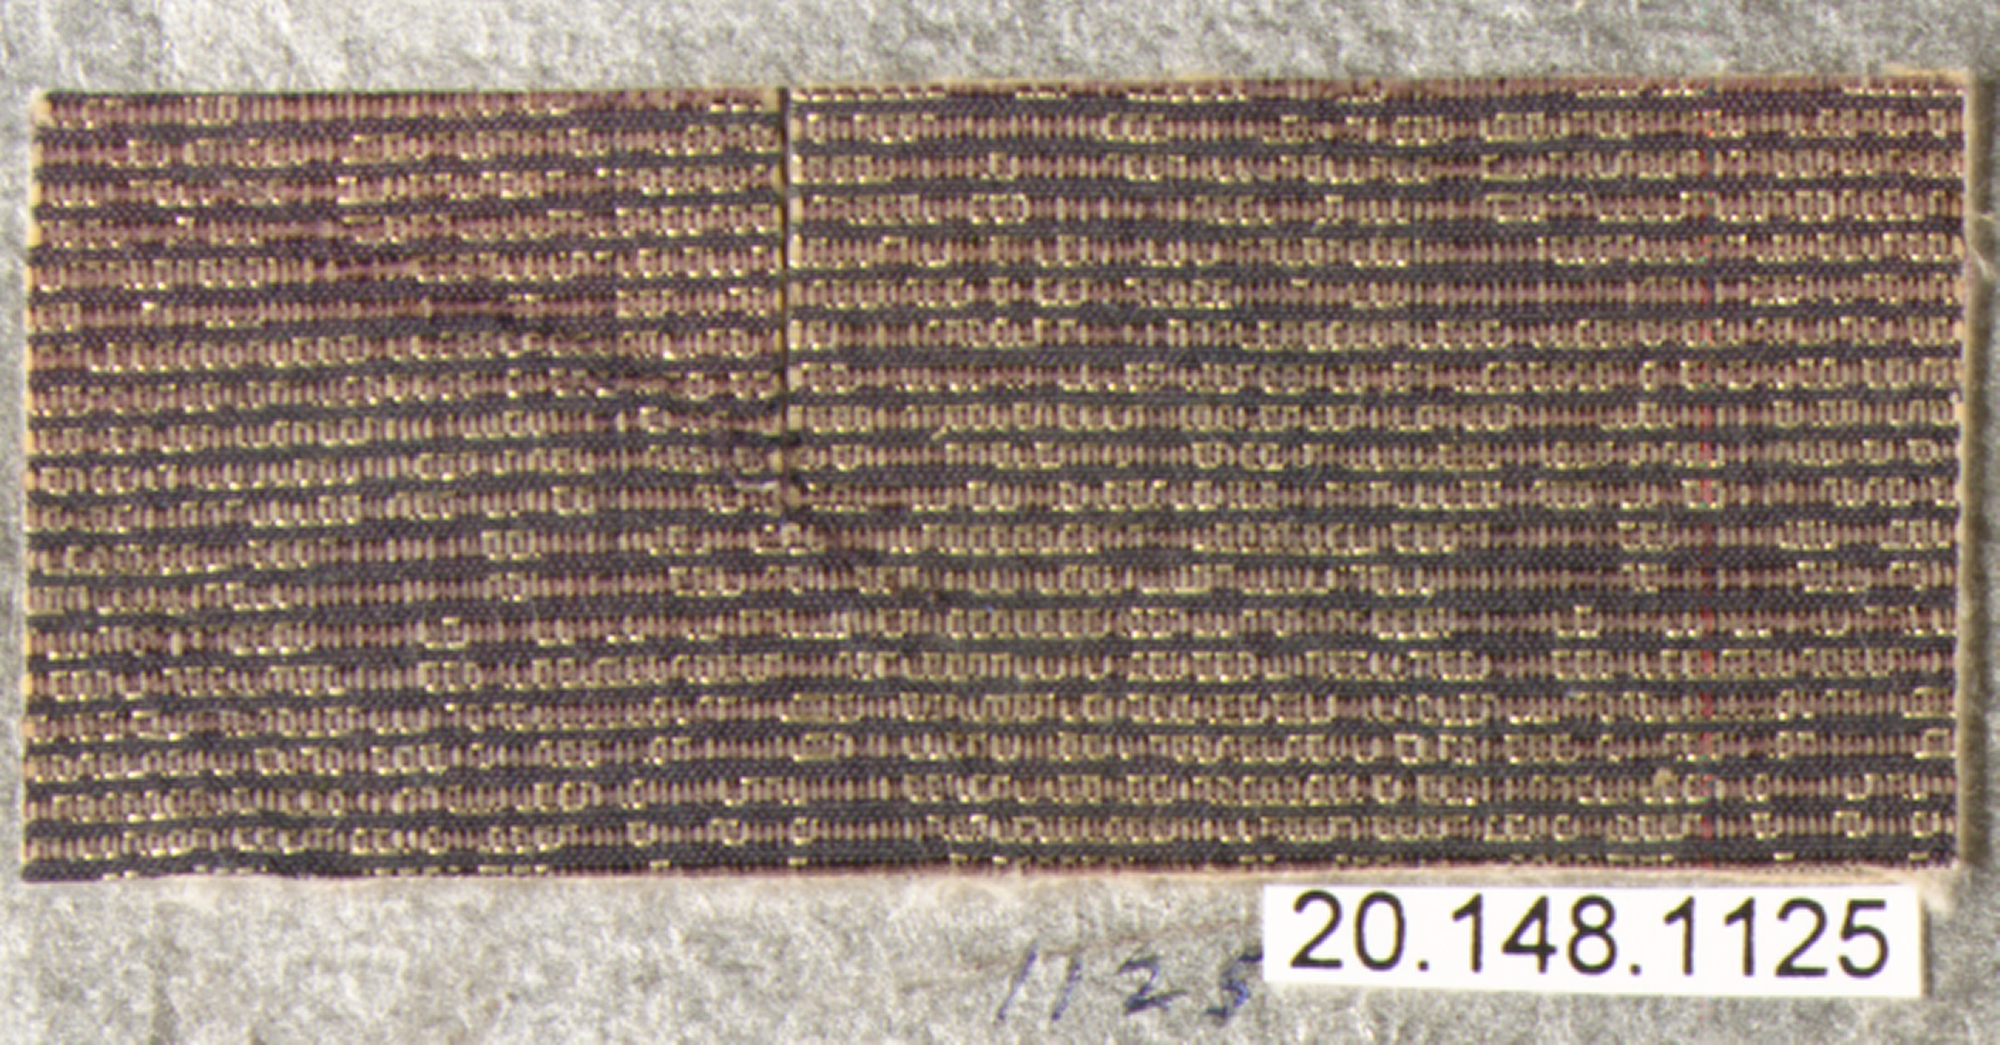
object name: piece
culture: japanese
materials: silk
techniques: compound weave